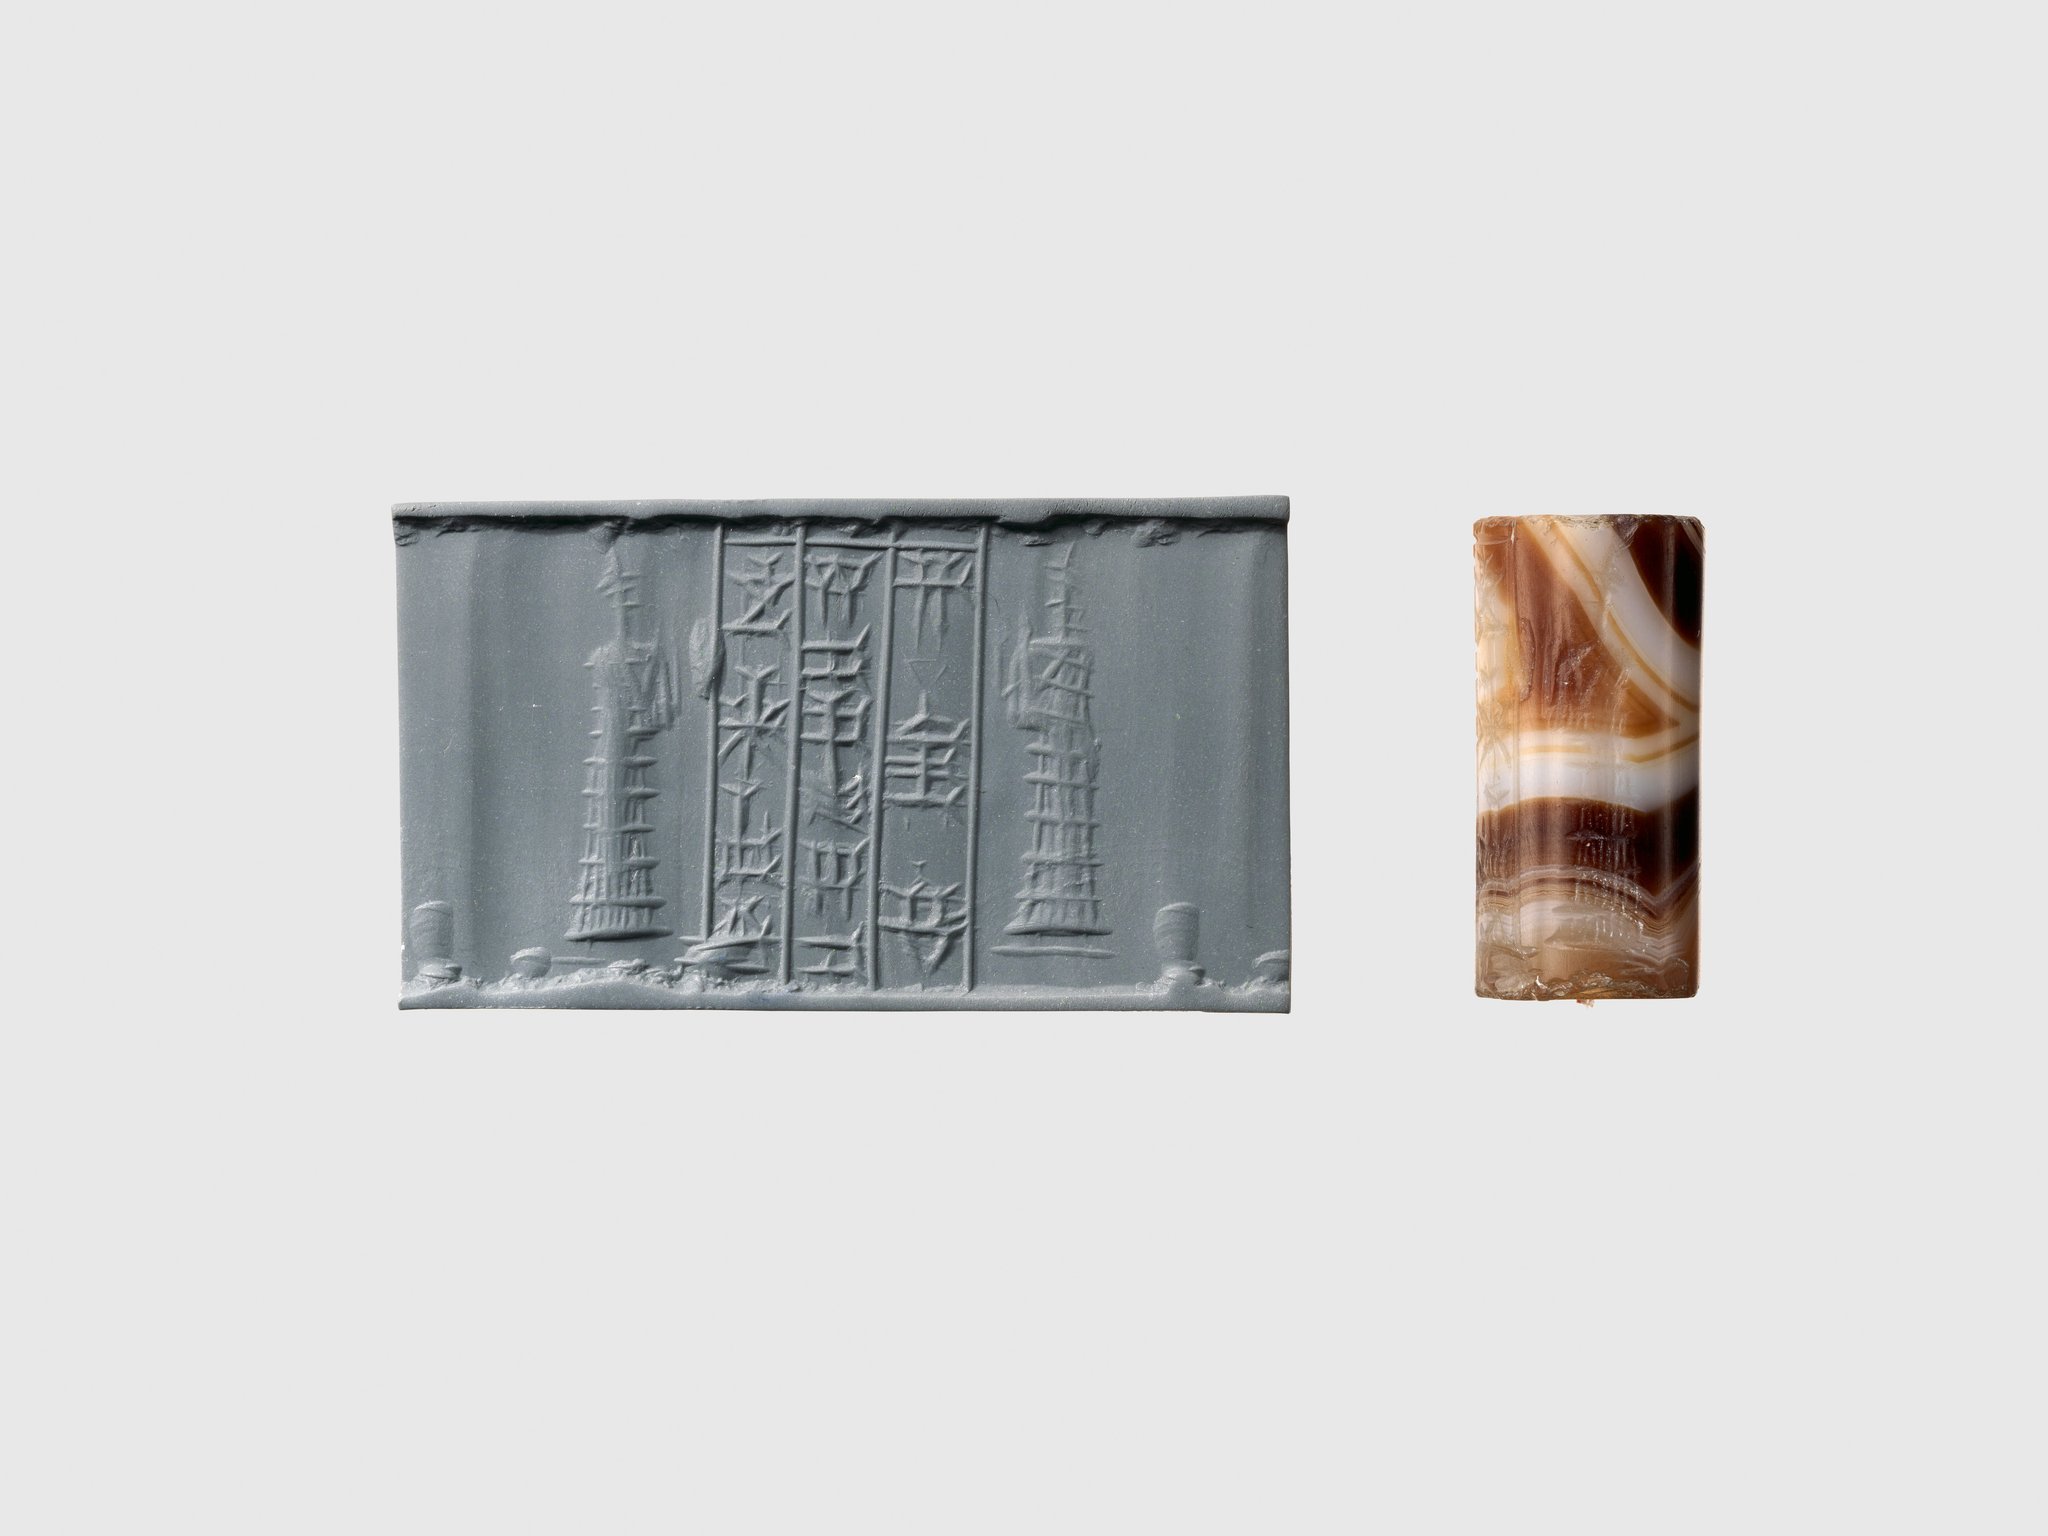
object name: cylinder seal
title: Cylinder seal and modern impression: suppliant goddesses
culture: babylonian or kassite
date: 1700-1501 BCE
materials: stone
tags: goddess